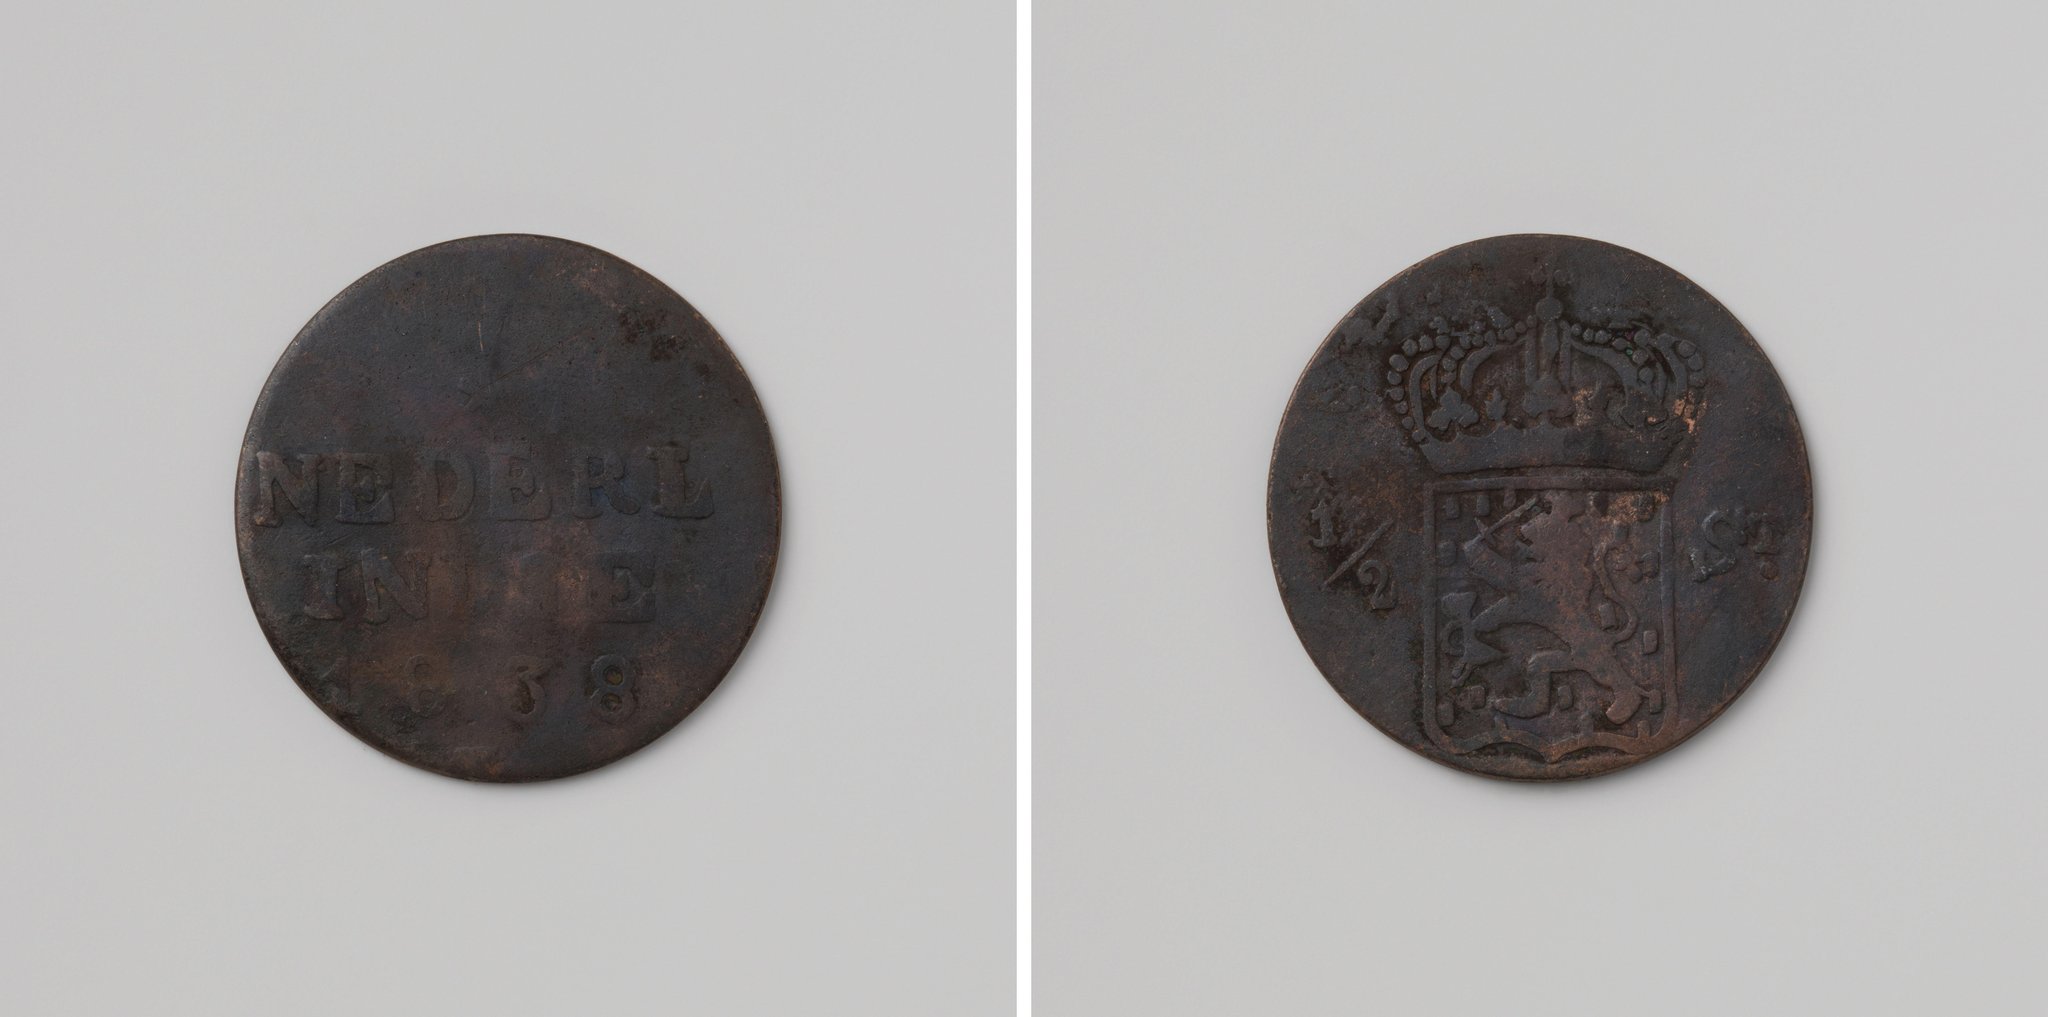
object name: coin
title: 1/2 VOC-stuiver van koper uit 1838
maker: Anonymous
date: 1838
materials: copper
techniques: striking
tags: dutch east indies, the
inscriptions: inscription: ‘NEDERL / INDIE / 1838’, inscription: ‘1/2 St’, inscription: ‘Jacques Schulman / Numismaat / Keizersgracht 448 / Amsterdam-C.’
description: Koperen 1/2 stuiver van de VOC uit Nederlands-Indië uit1838. Voorzijde: opschrift. Keerzijde: een gekroond wapen met leeuw erin en links ervan staat 1/2, rechts ervan staan de letters St. Het muntje zit in een vierkant envelopje met opschrift.